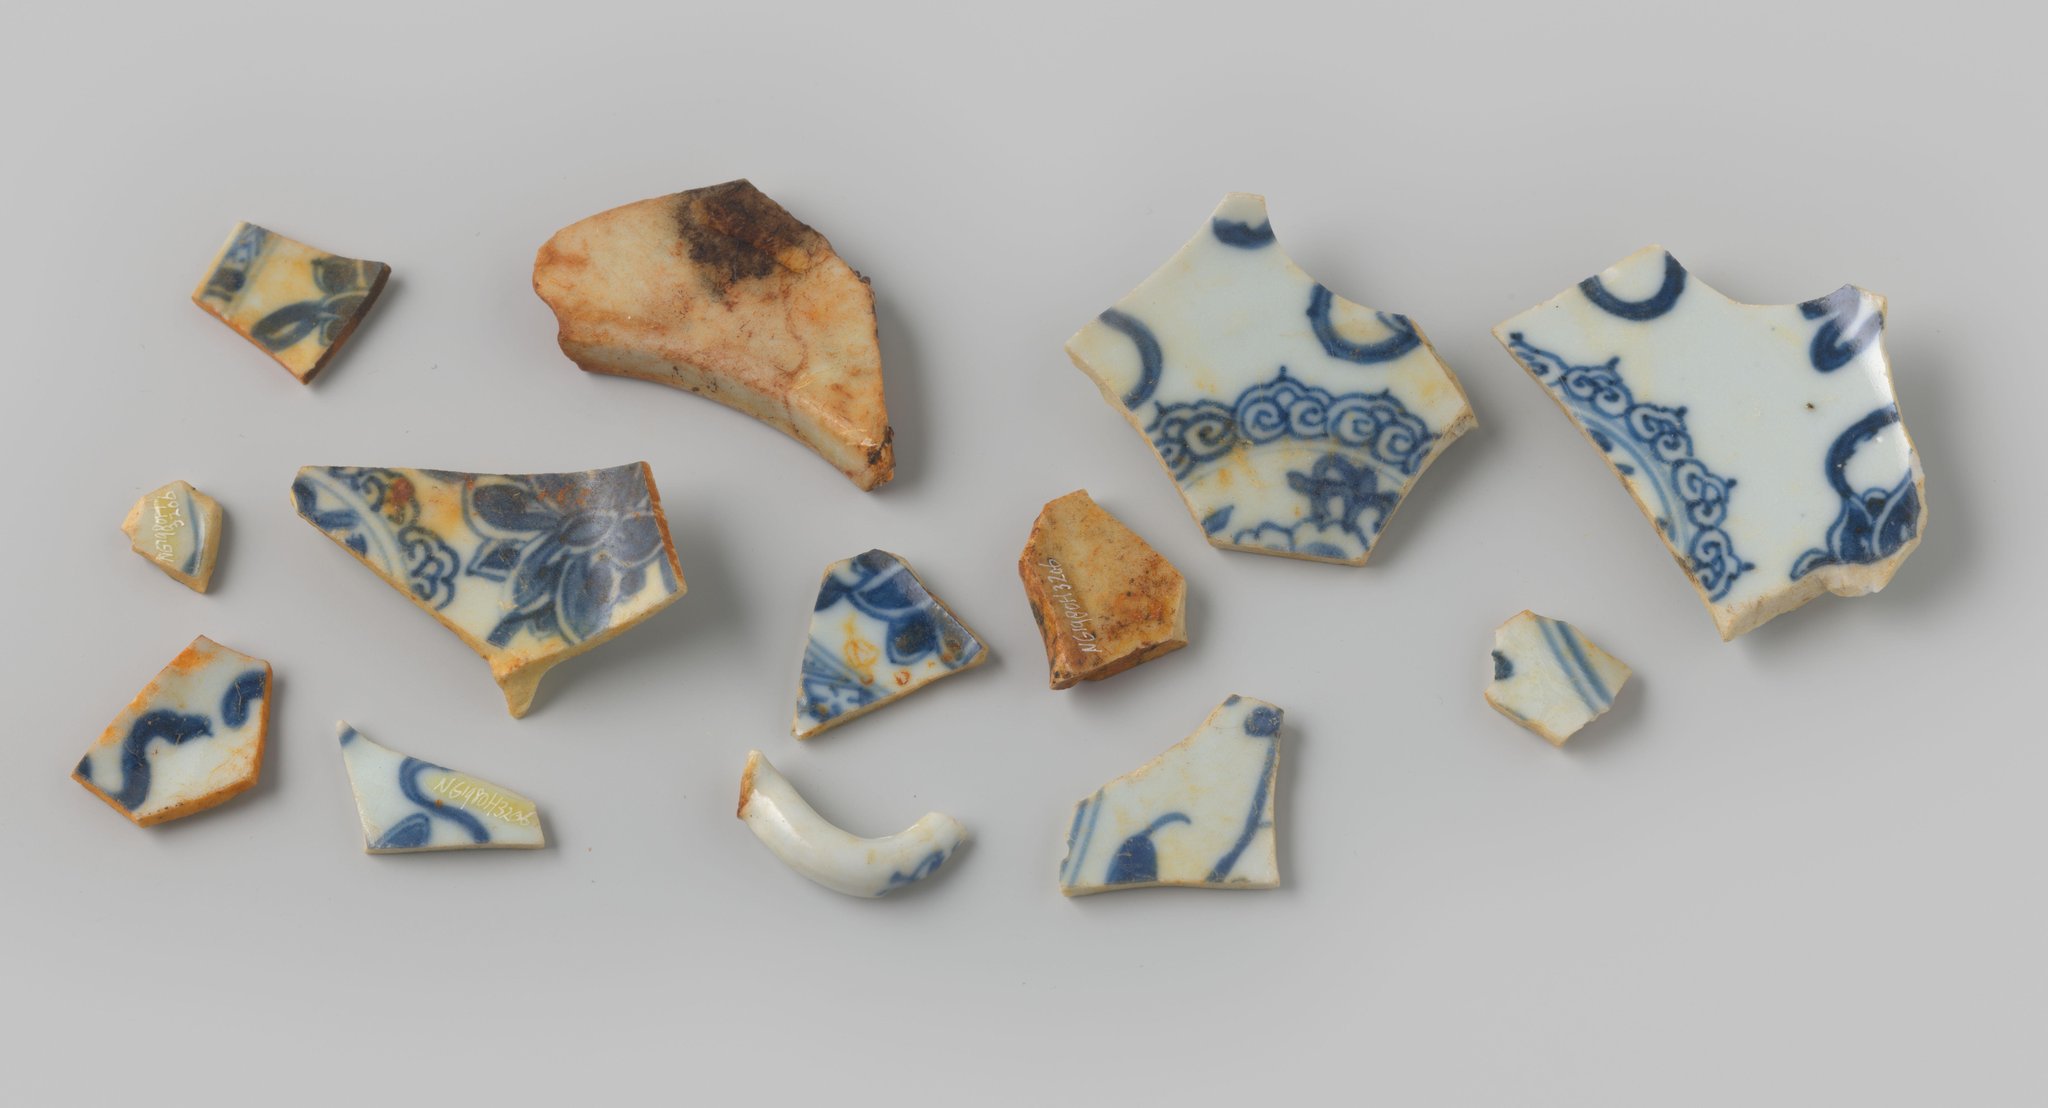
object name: sherd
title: Porseleinen scherven uit het wrak van de Oost-Indiëvaarder Hollandia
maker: Anonymous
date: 1700-1743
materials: porcelain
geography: netherlands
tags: verenigde oostindische compagnie, hollandia (schip), annet